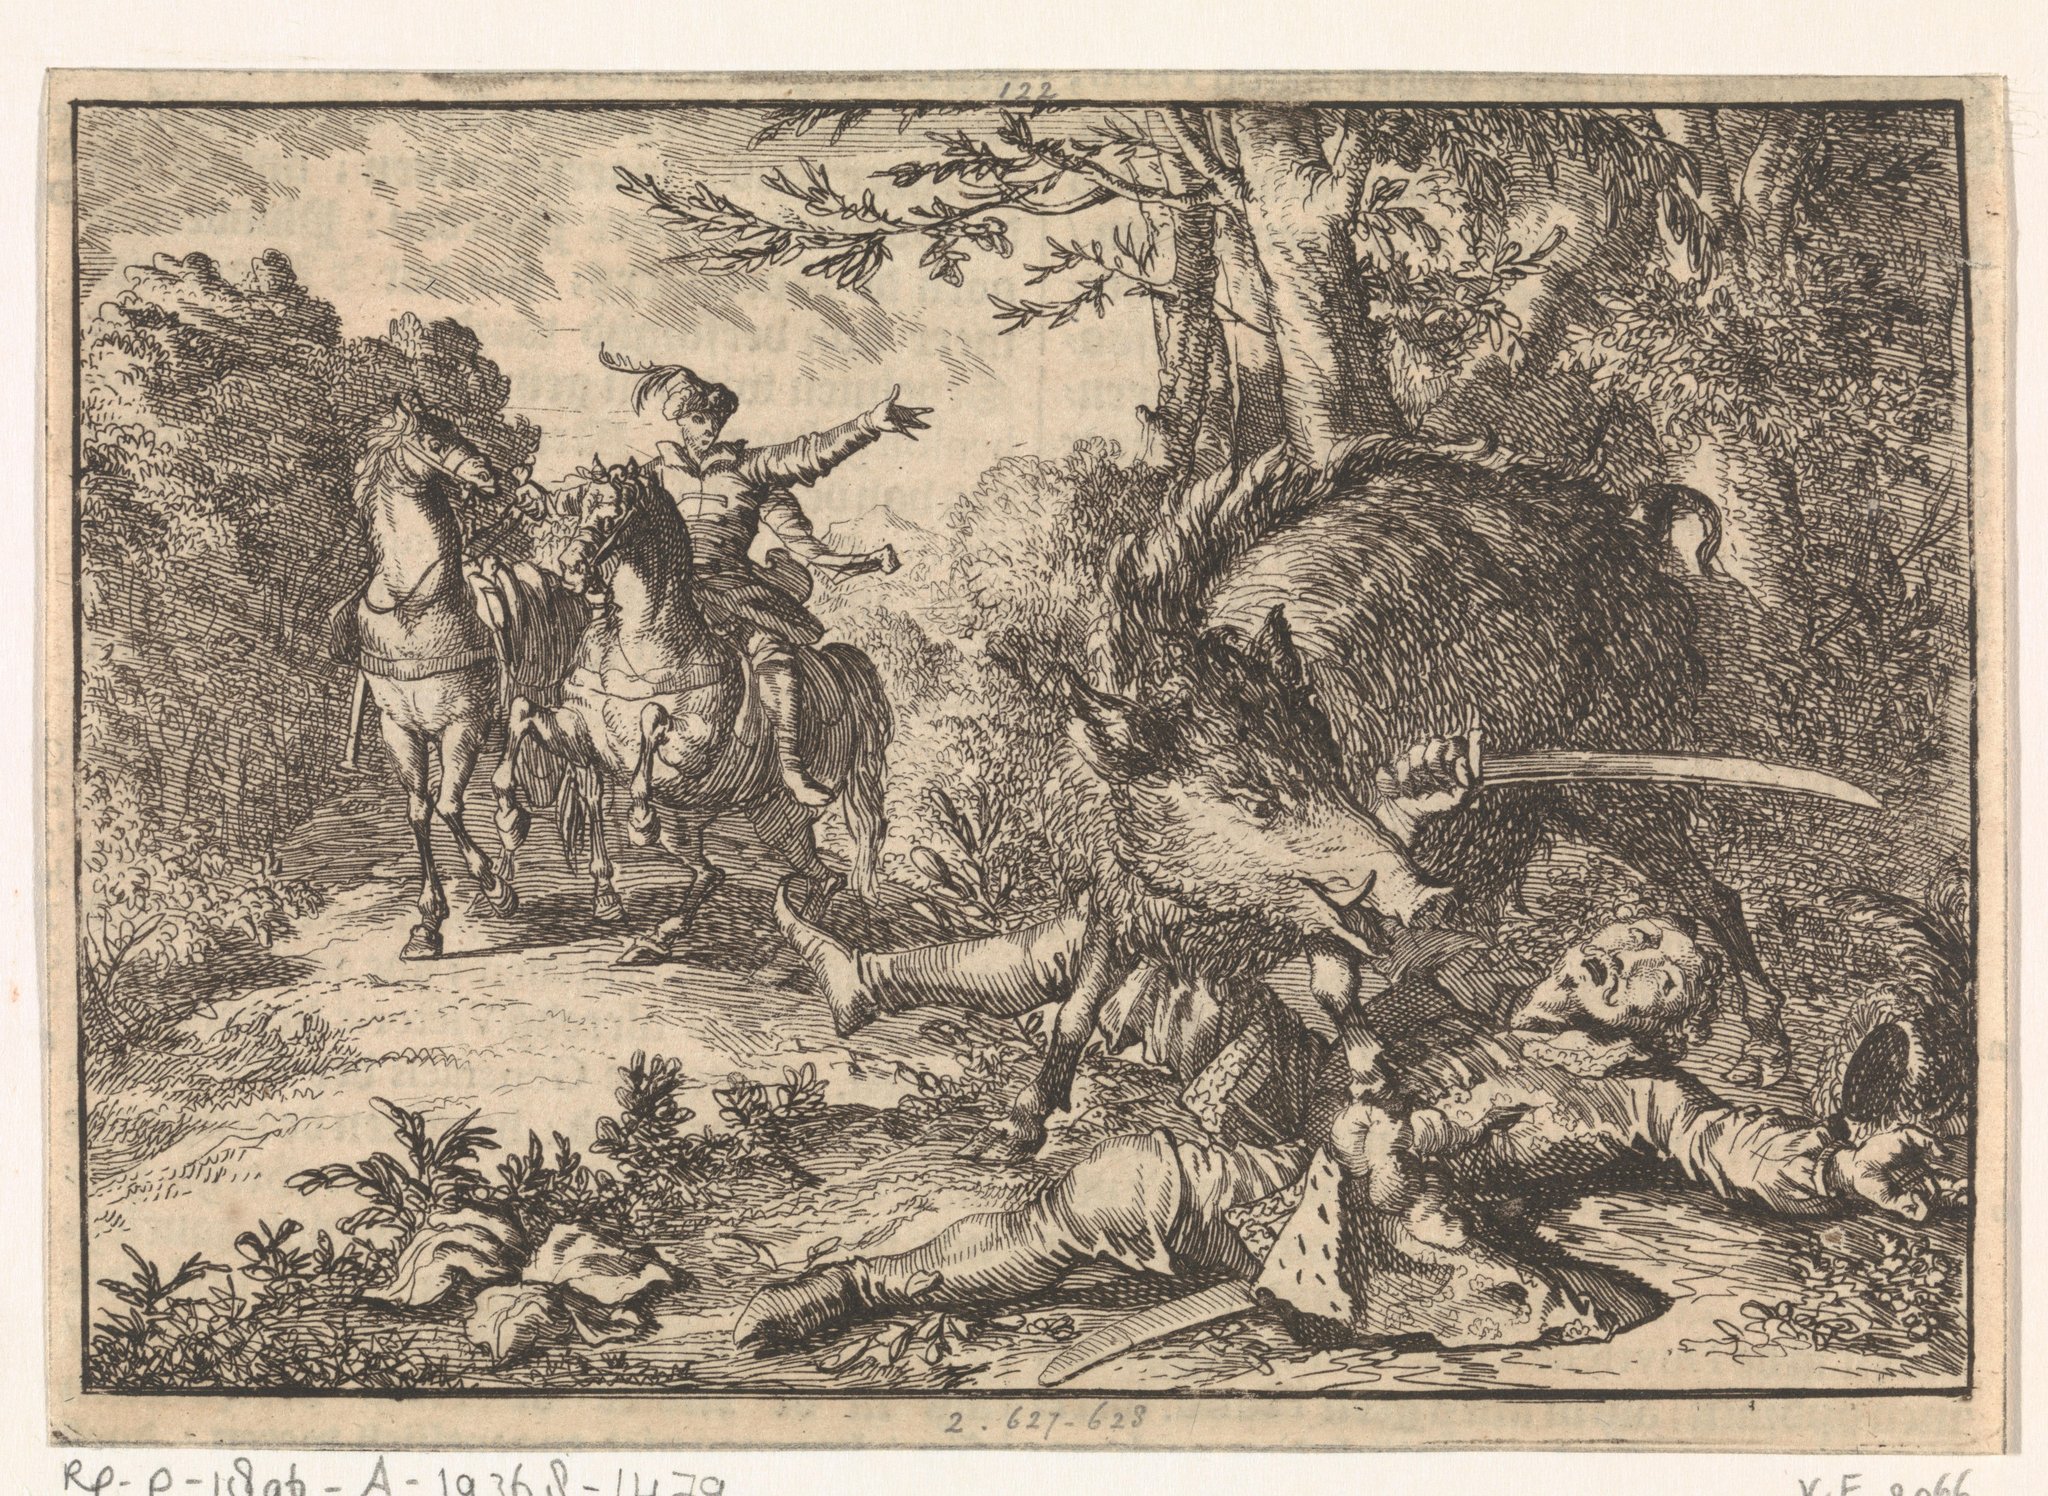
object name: book illustration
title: Miklós graaf van Zrínyi in Kroatië gedood door een wild zwijn, 1664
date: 1698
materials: paper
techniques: etching, letterpress printing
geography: leiden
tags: hoofed animals: boar, animal killing man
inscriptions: collector's mark: Lugt 2228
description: Illustratie uit: Gottfried, Johann Ludwig. Historische kronyck; vervattende een (...) beschrijvingh der aldergedenckwaerdigste geschiedenissen des weerelds, van den aenvangh der scheppingh tot (...) 1576 (2 delen). Leiden: Pieter van der Aa, 1698, dl. II, p. 627.